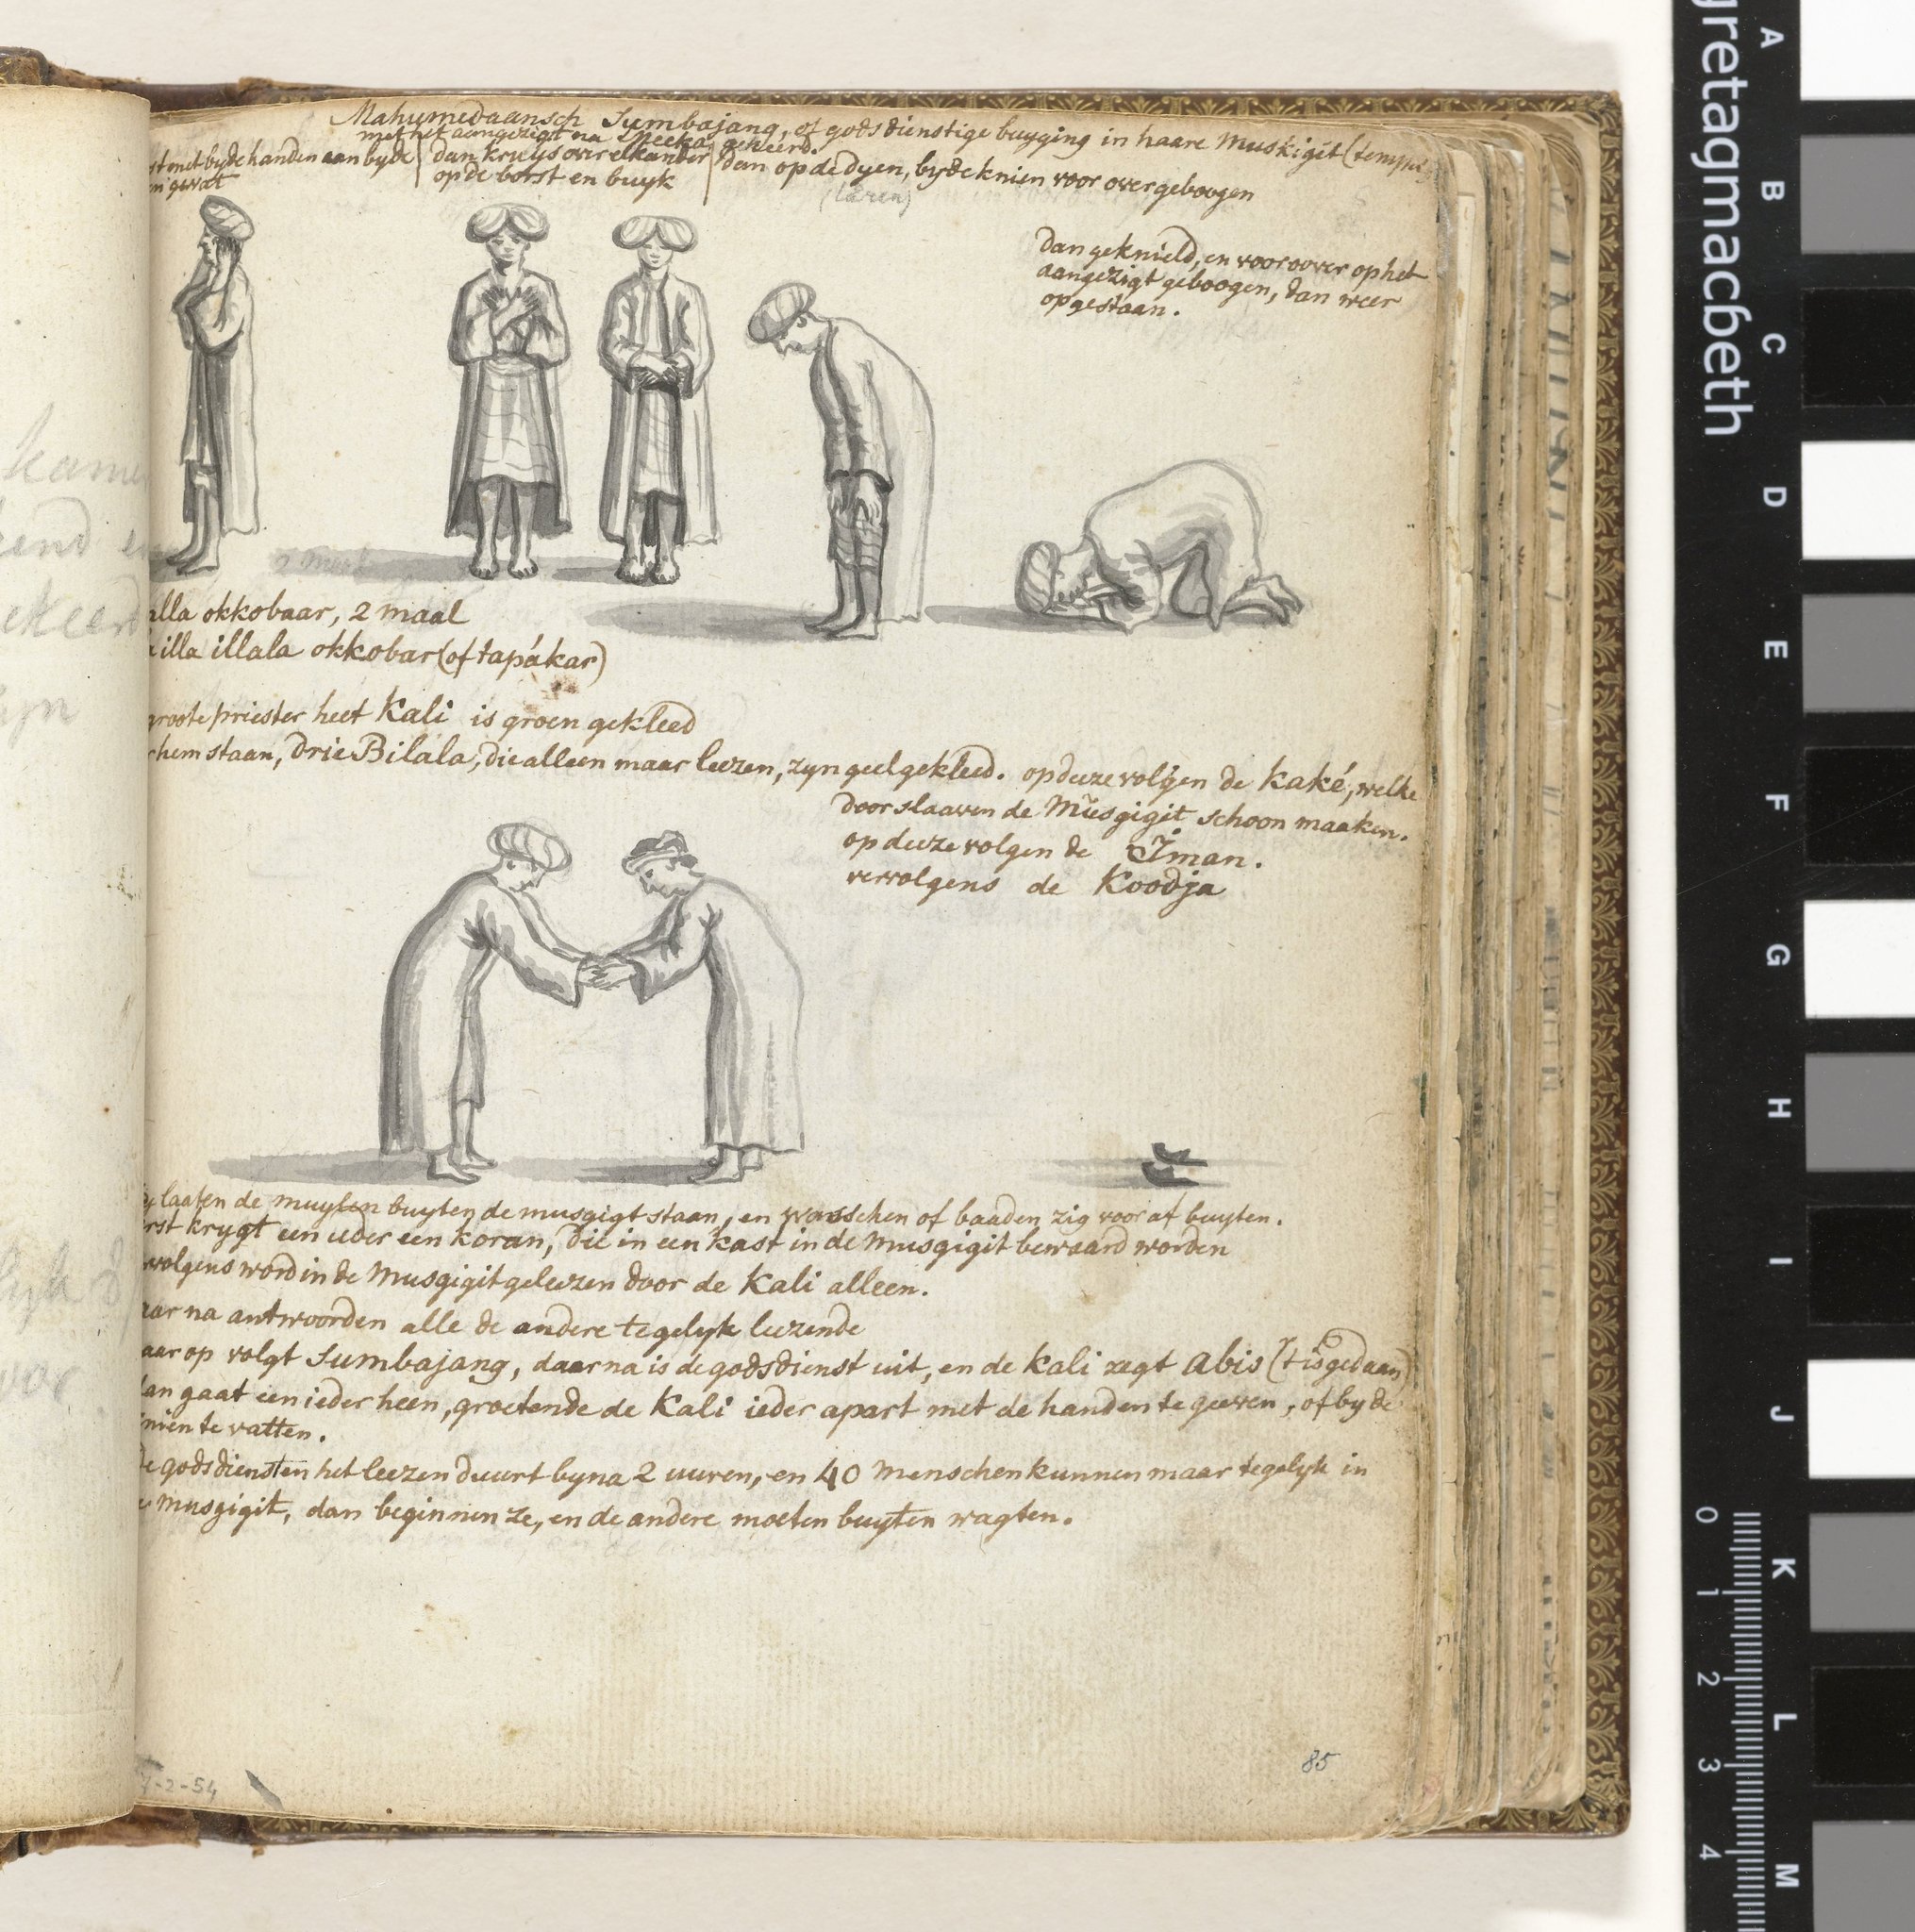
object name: drawing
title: Mohammedaanse buiging en begroeting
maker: jan brandes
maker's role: draughtsman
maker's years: 1743-1808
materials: ink, paper, pencil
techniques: brush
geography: jakarta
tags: ritual practices ~ islam, mohammedanism, religious functionaries ~ islam, mohammedanism, batavia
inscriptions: inscription: ‘Mahumedaansch sumbajang, of godsdienstige buyging in haare Muskigit (tempel) met het aangezigt na Mecka gekeerd. Eerst met beyde handen aan bydeooren gevat dan kruys over elkander op de borst en buyk dan op de dyen, by de knien voor overgeboogen dan geknield, en vooroover op het aangezigt geboogen, dan weer opgestaan...’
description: Zwartwittekening van mannelijke moslims in gewaden en met tulband en hun manier van bidden naar Mekka en de manier van begroeten van de imam. Met opschrift. Onderdeel uit het schetsboek van Jan Brandes, dl. 2 (1808), p. 85.